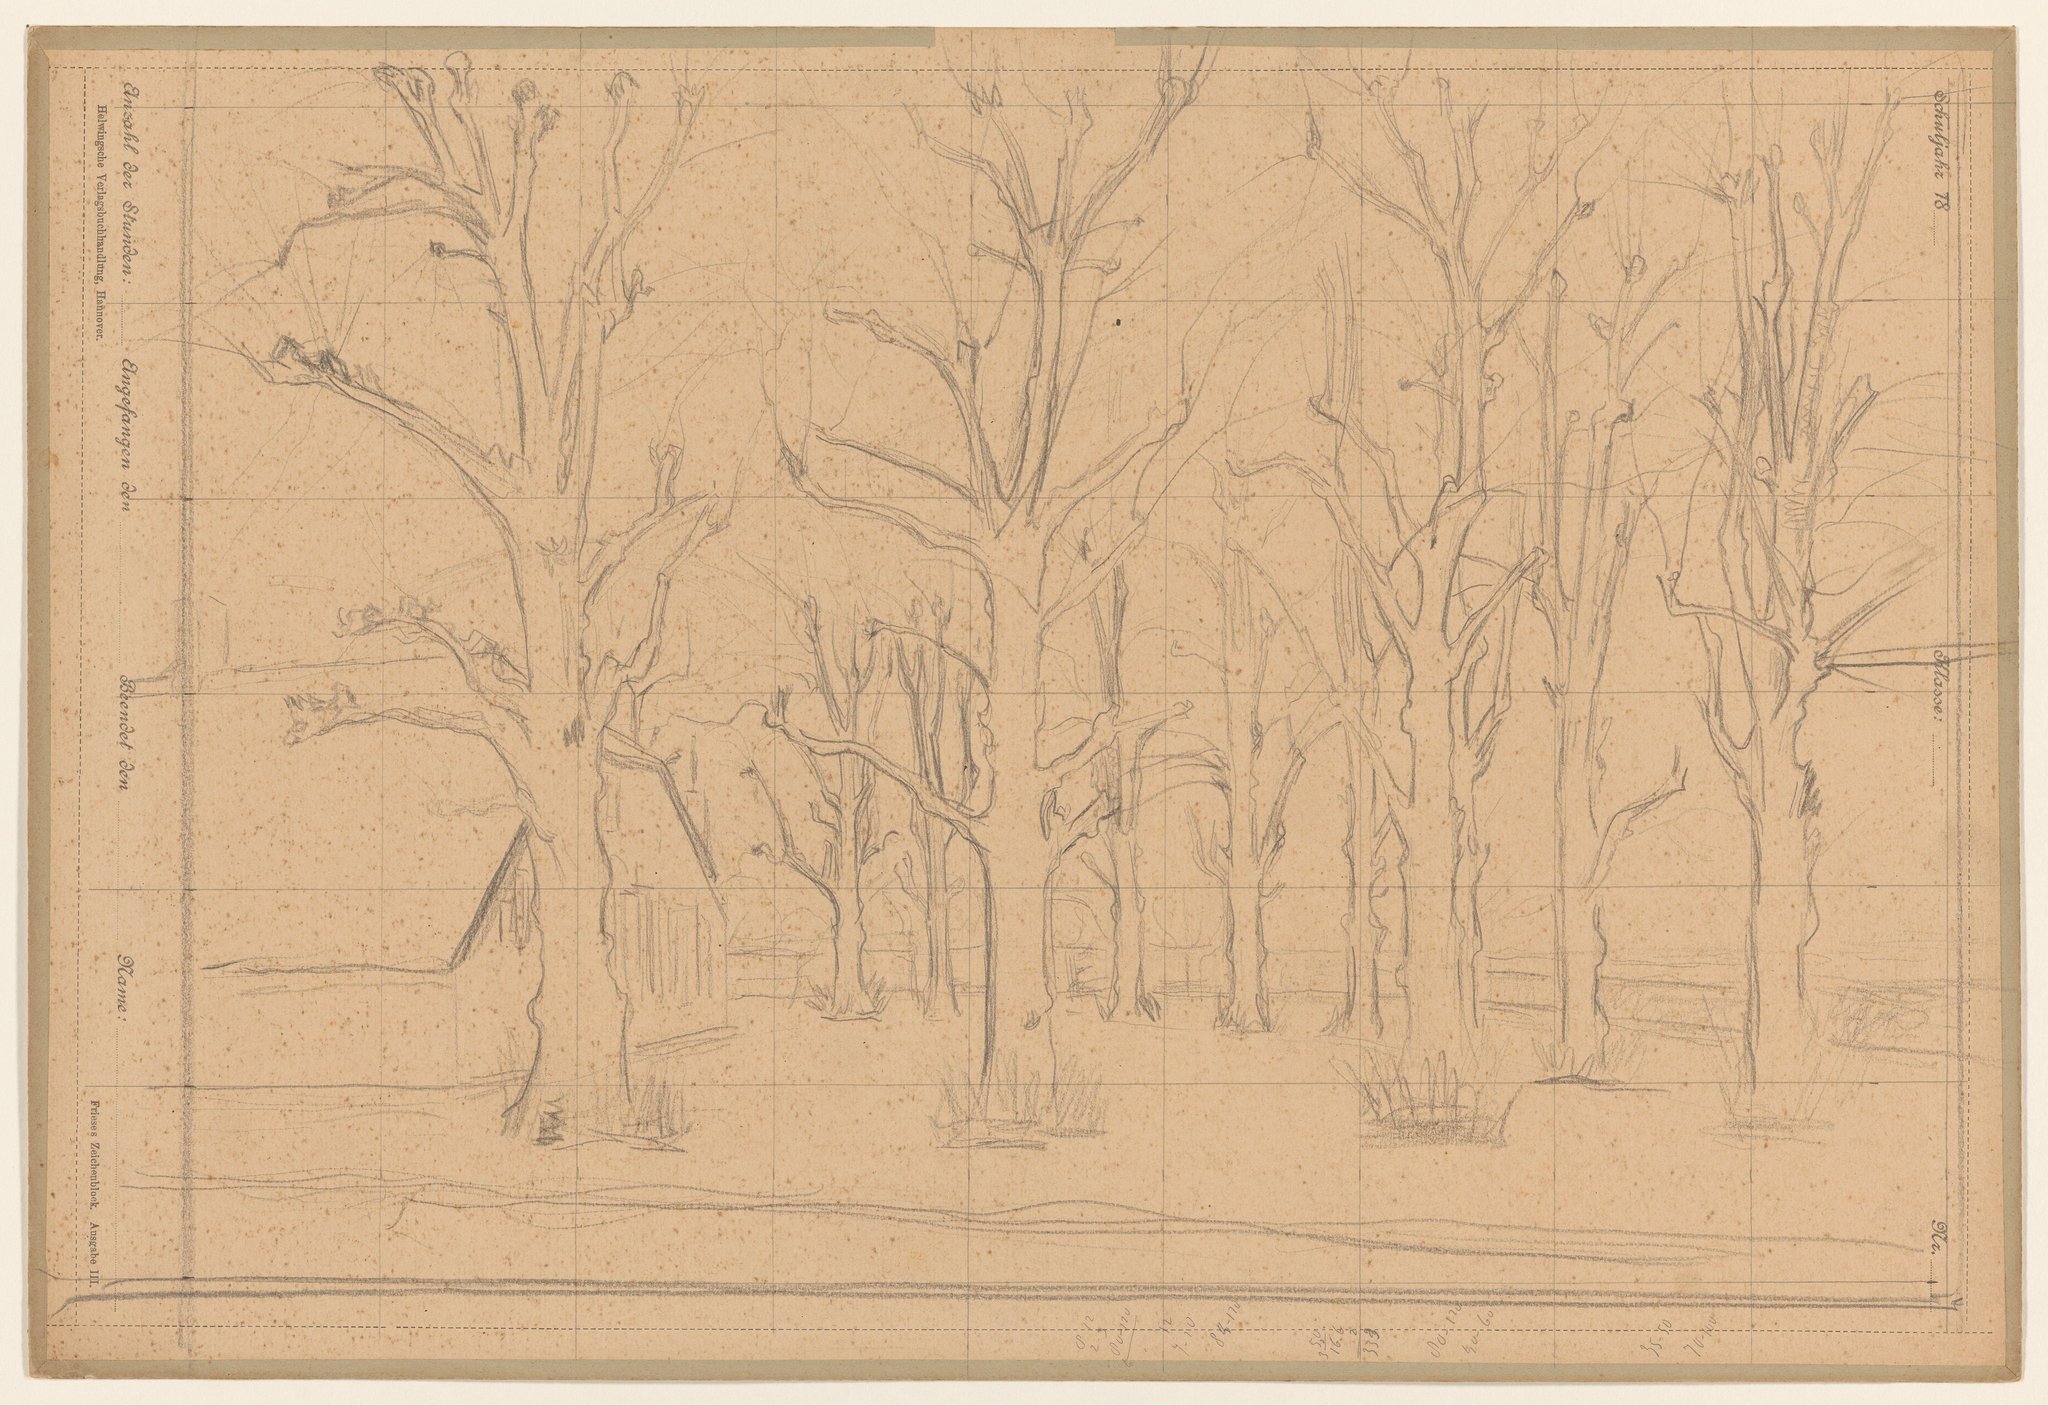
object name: drawing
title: Studie van kale bomen (de Jansweg te Laren)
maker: ferdinand hart nibbrig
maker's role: draughtsman, painter, print maker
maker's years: 1866-1915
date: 1876-1915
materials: paper, pencil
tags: trees, factories and mills in landscape